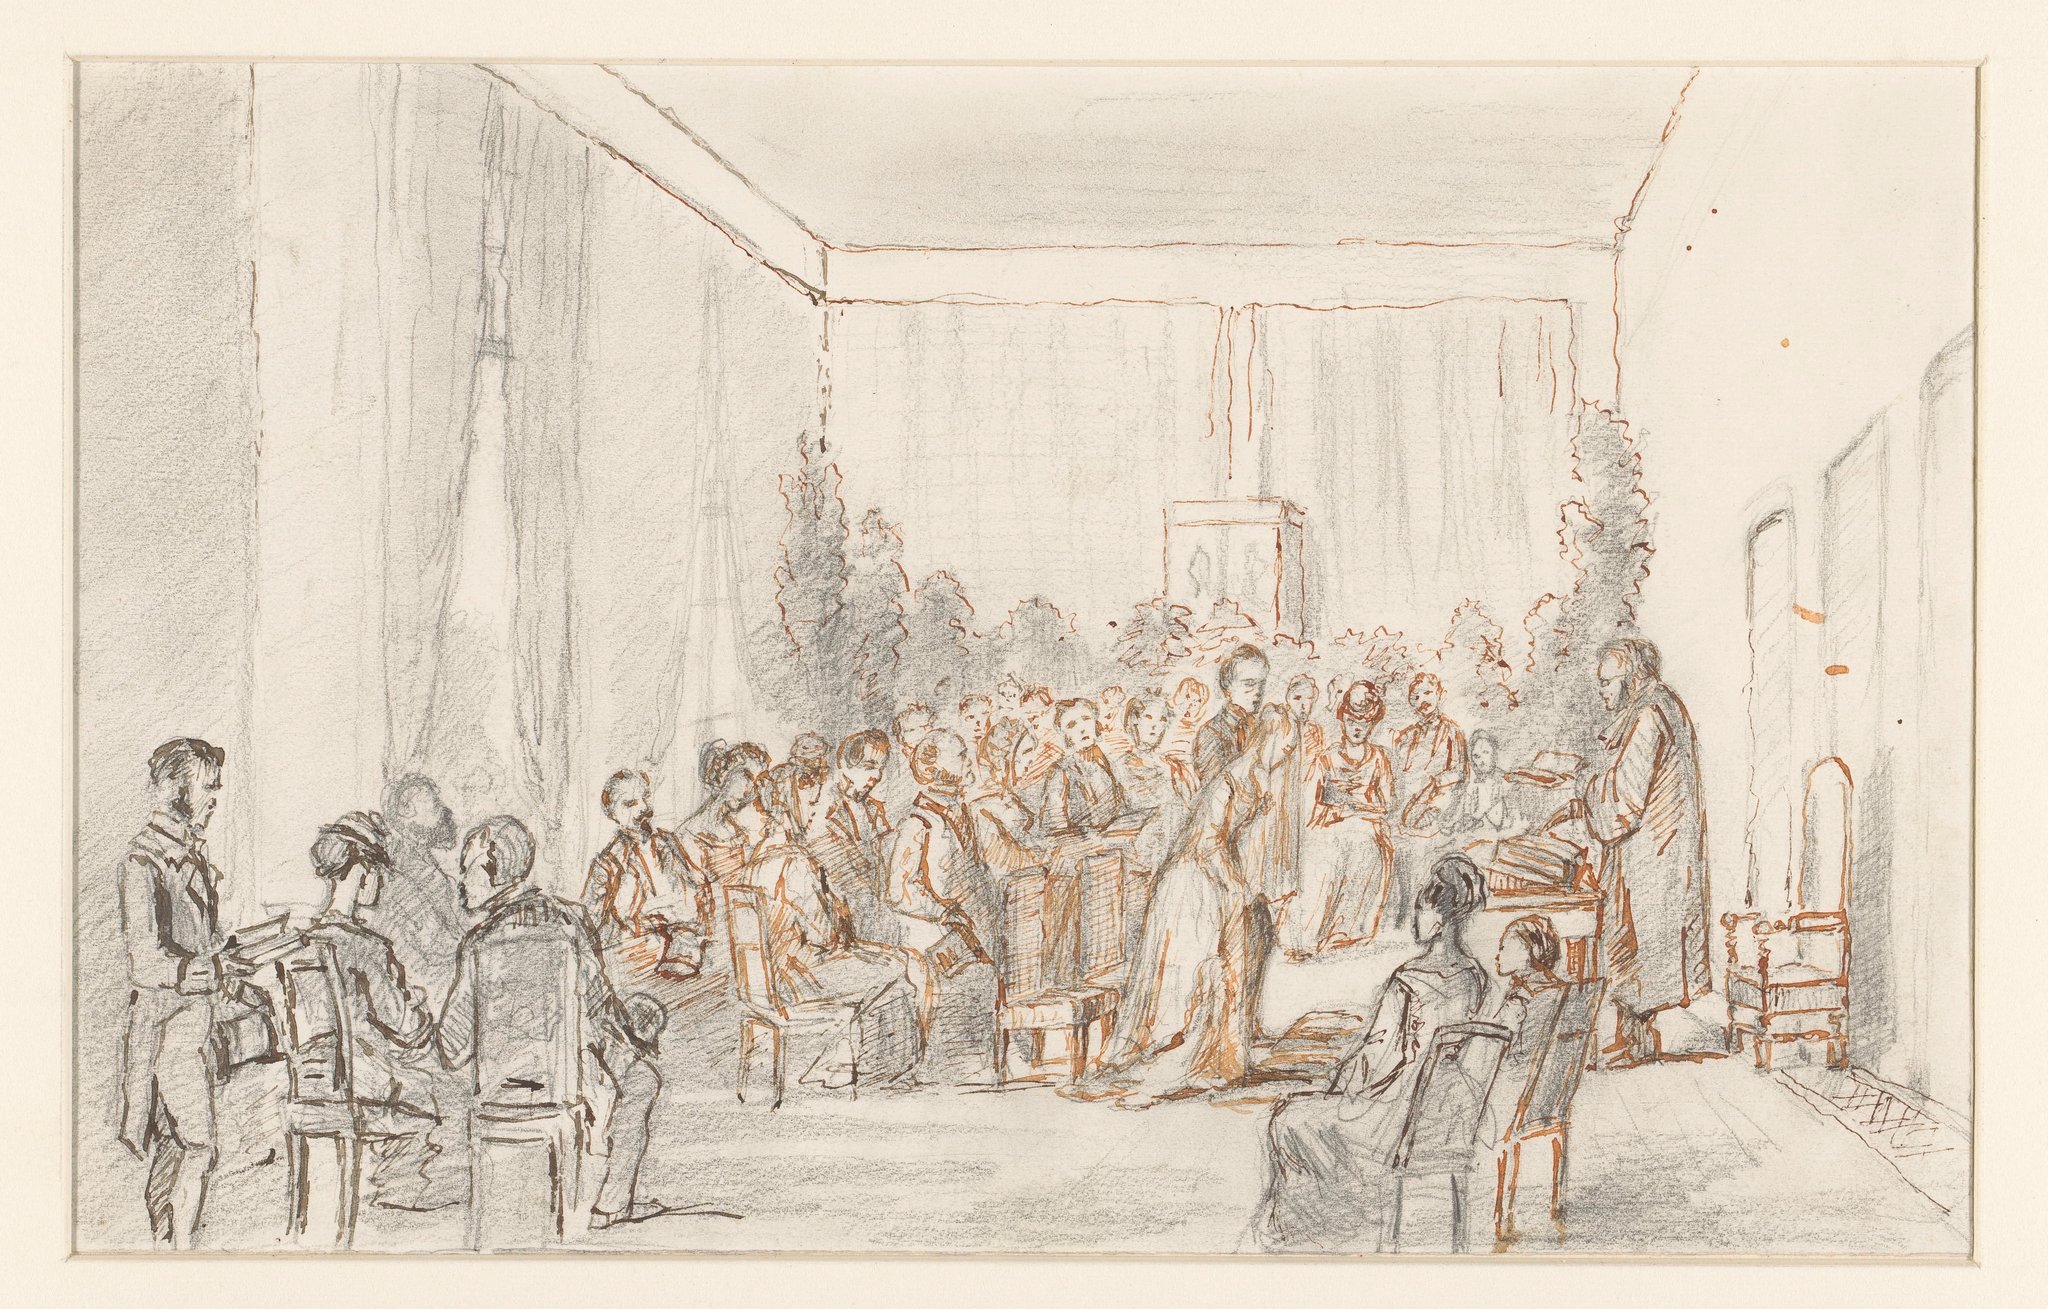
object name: drawing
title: Huwelijks inzegening van Gerard Jacob Theodoor Beelaerts van Blokland en Johanna Maria Kneppelhout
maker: Anonymous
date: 1870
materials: ink, paper, pencil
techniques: pen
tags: haarlem, utrecht, nicolaas beets, rotterdam, the hague, (civil) marriage ceremonies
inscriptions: date: ‘15. Julij 1870’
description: Huwelijks inzegening door Dominee Nicolaas Beets van Gerard Jacob Theodoor Beelaerts van Blokland en Johanna Maria Kneppelhout in de orangerie op Sterkenburg.